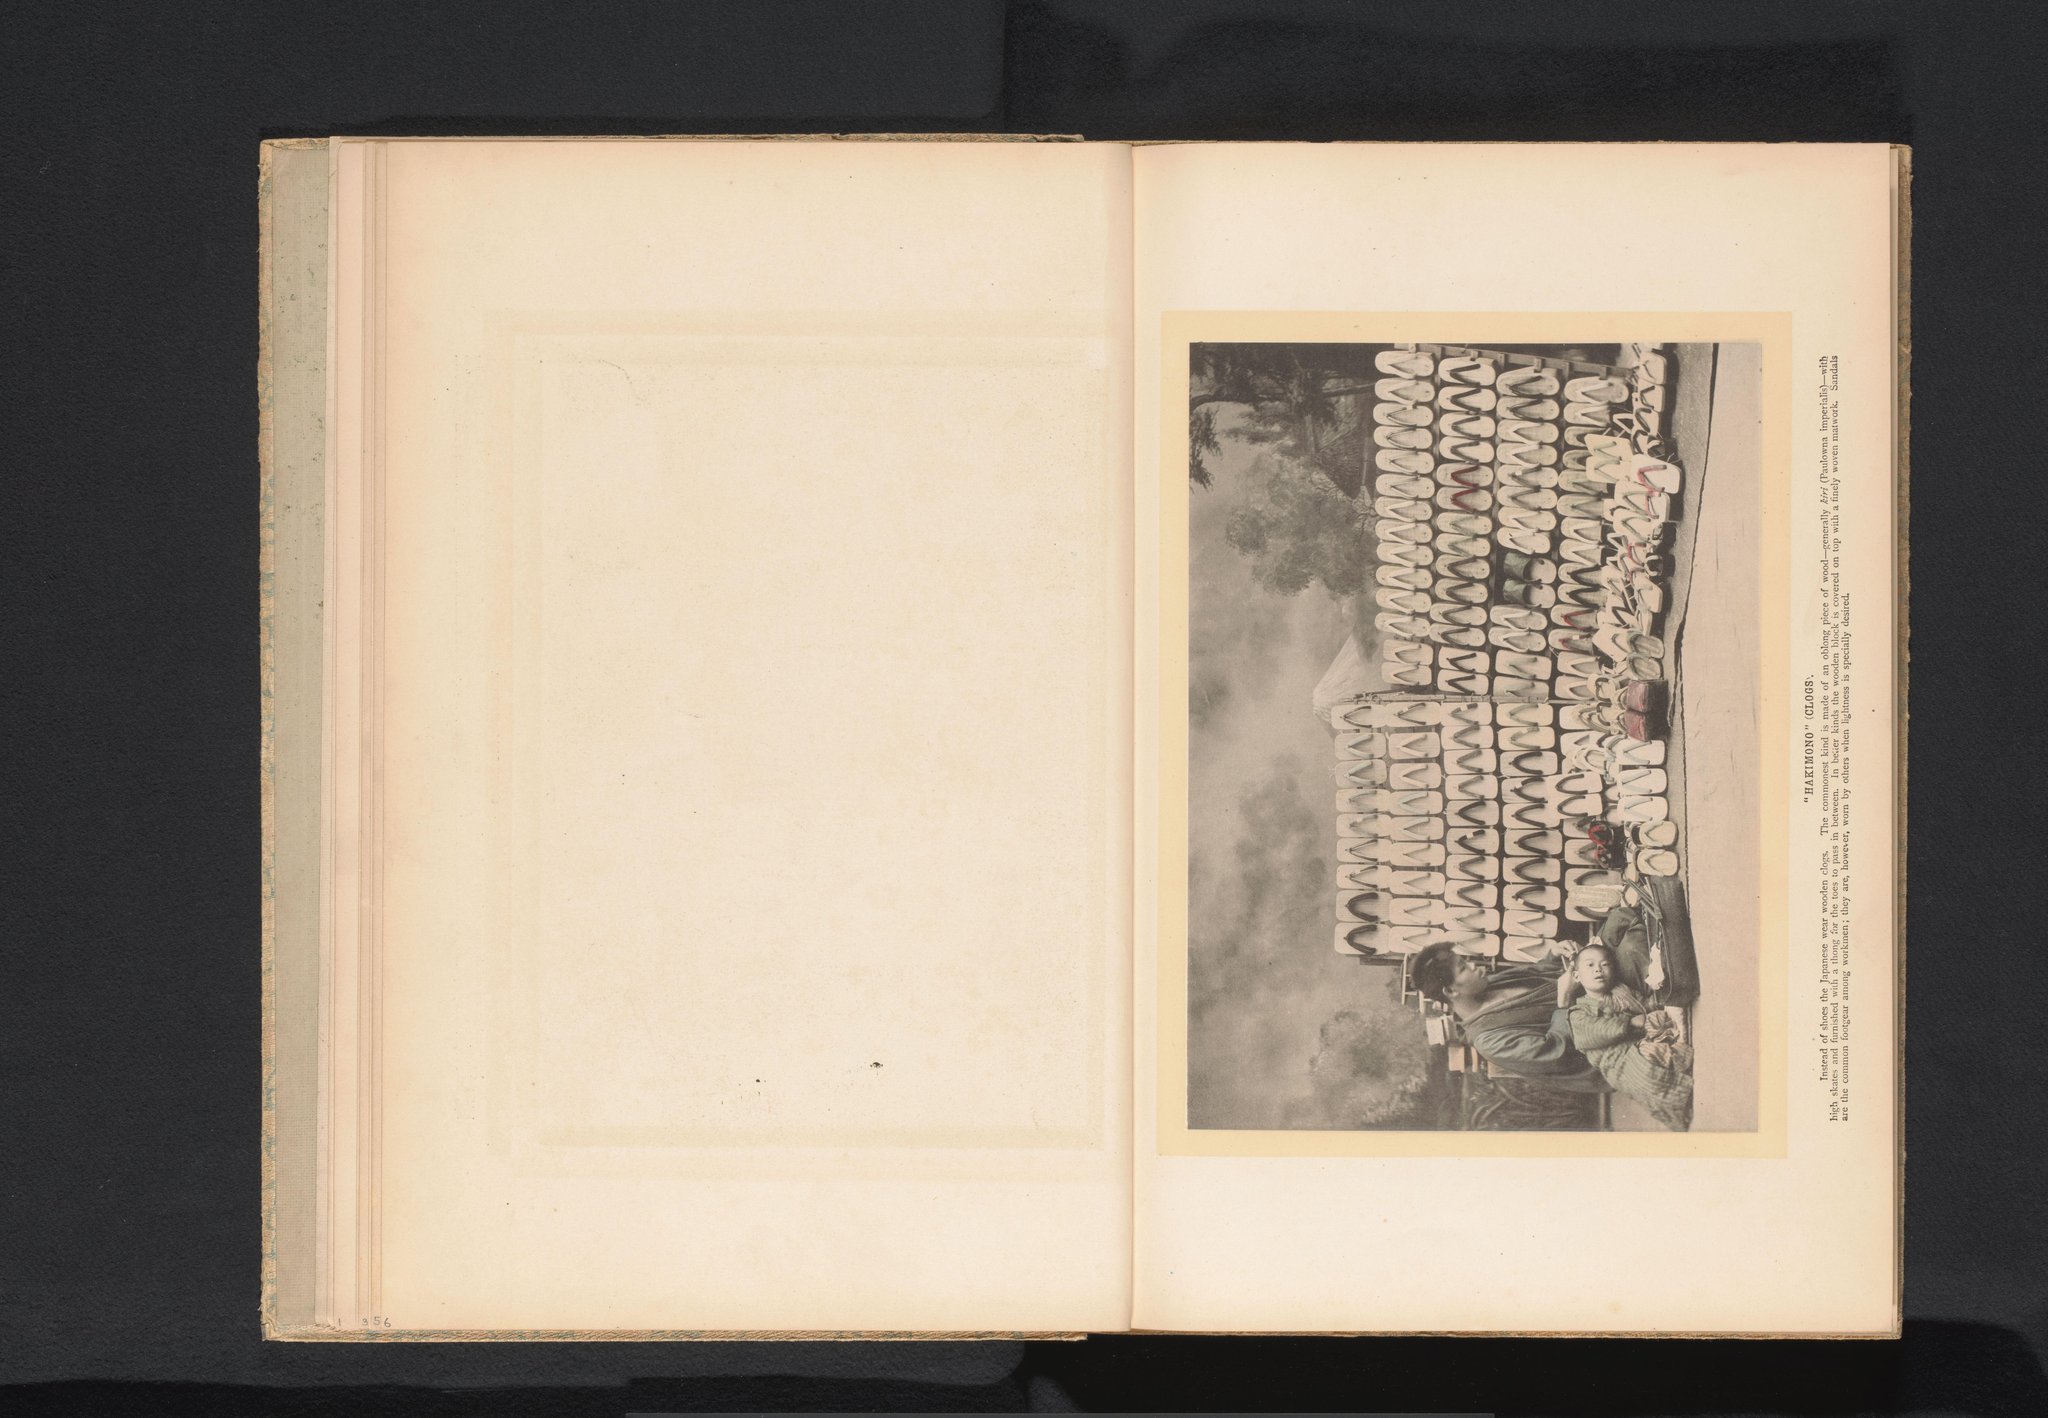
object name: page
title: "Hakimono" (Clogs)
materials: paper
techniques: photograph, lithograph, hand coloring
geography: tokyo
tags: gear for legs and feet, merchant, salesman, japan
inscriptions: inscription: ‘Instead of (...) specially desired.’